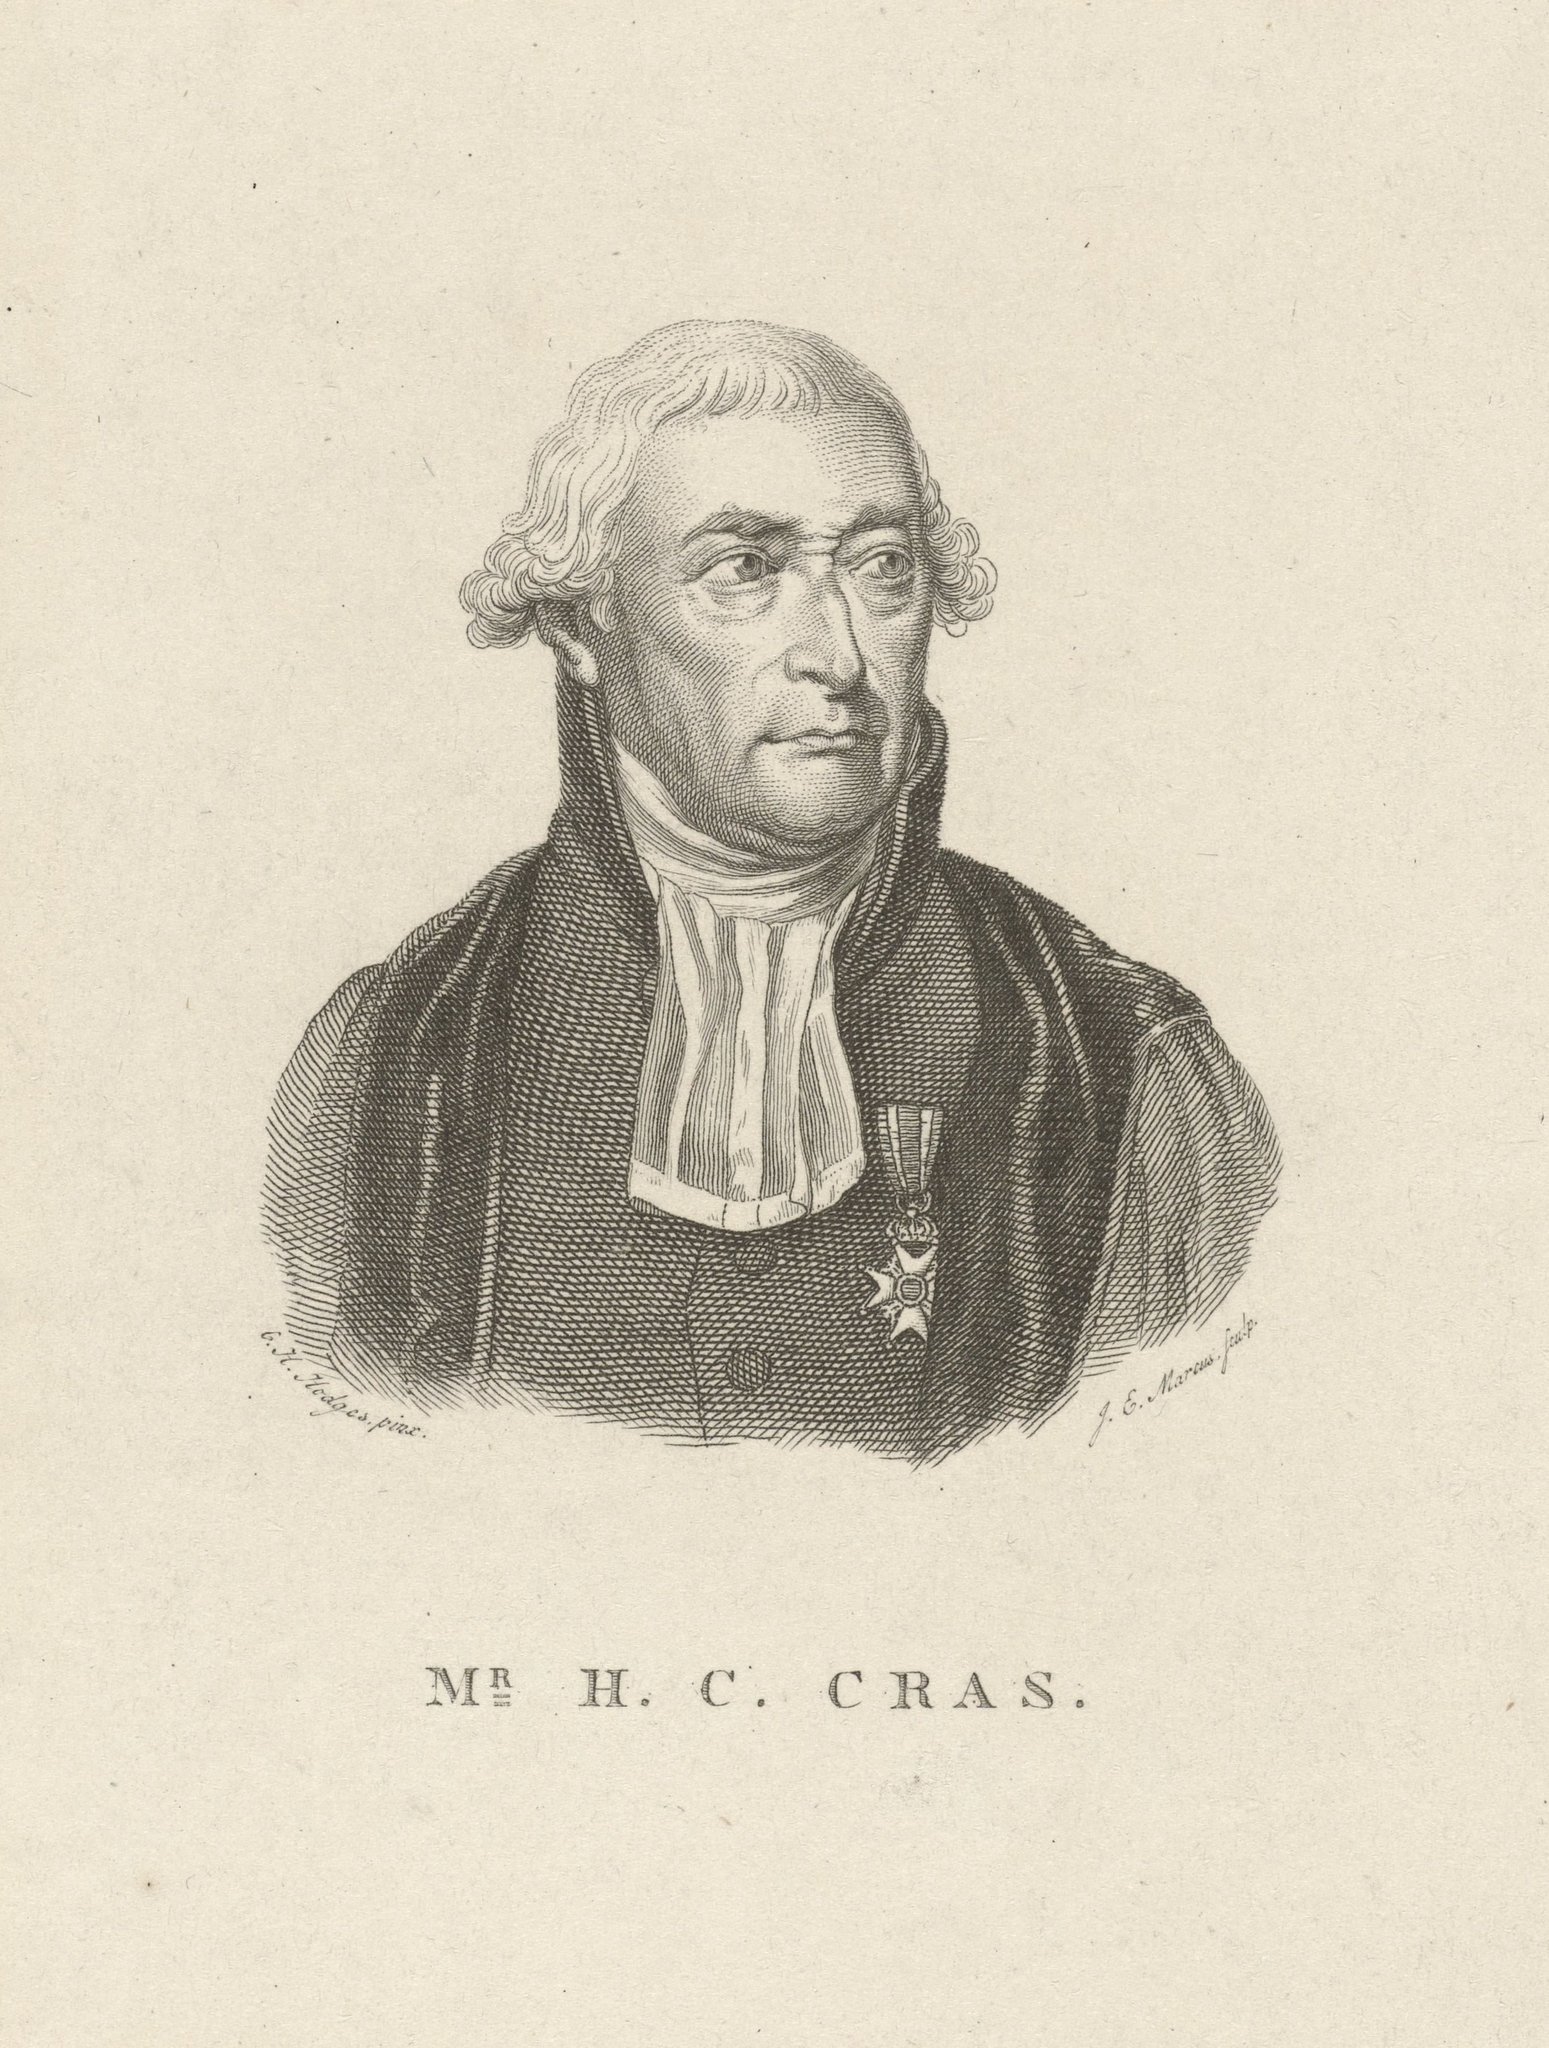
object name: print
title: Portret van Hendrik Constantijn Cras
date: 1784-1826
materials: paper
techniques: engraving, etching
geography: amsterdam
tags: leiden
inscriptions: collector's mark: Lugt 2228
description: Portret van de rechtsgeleerde Hendrik Constantijn Cras.